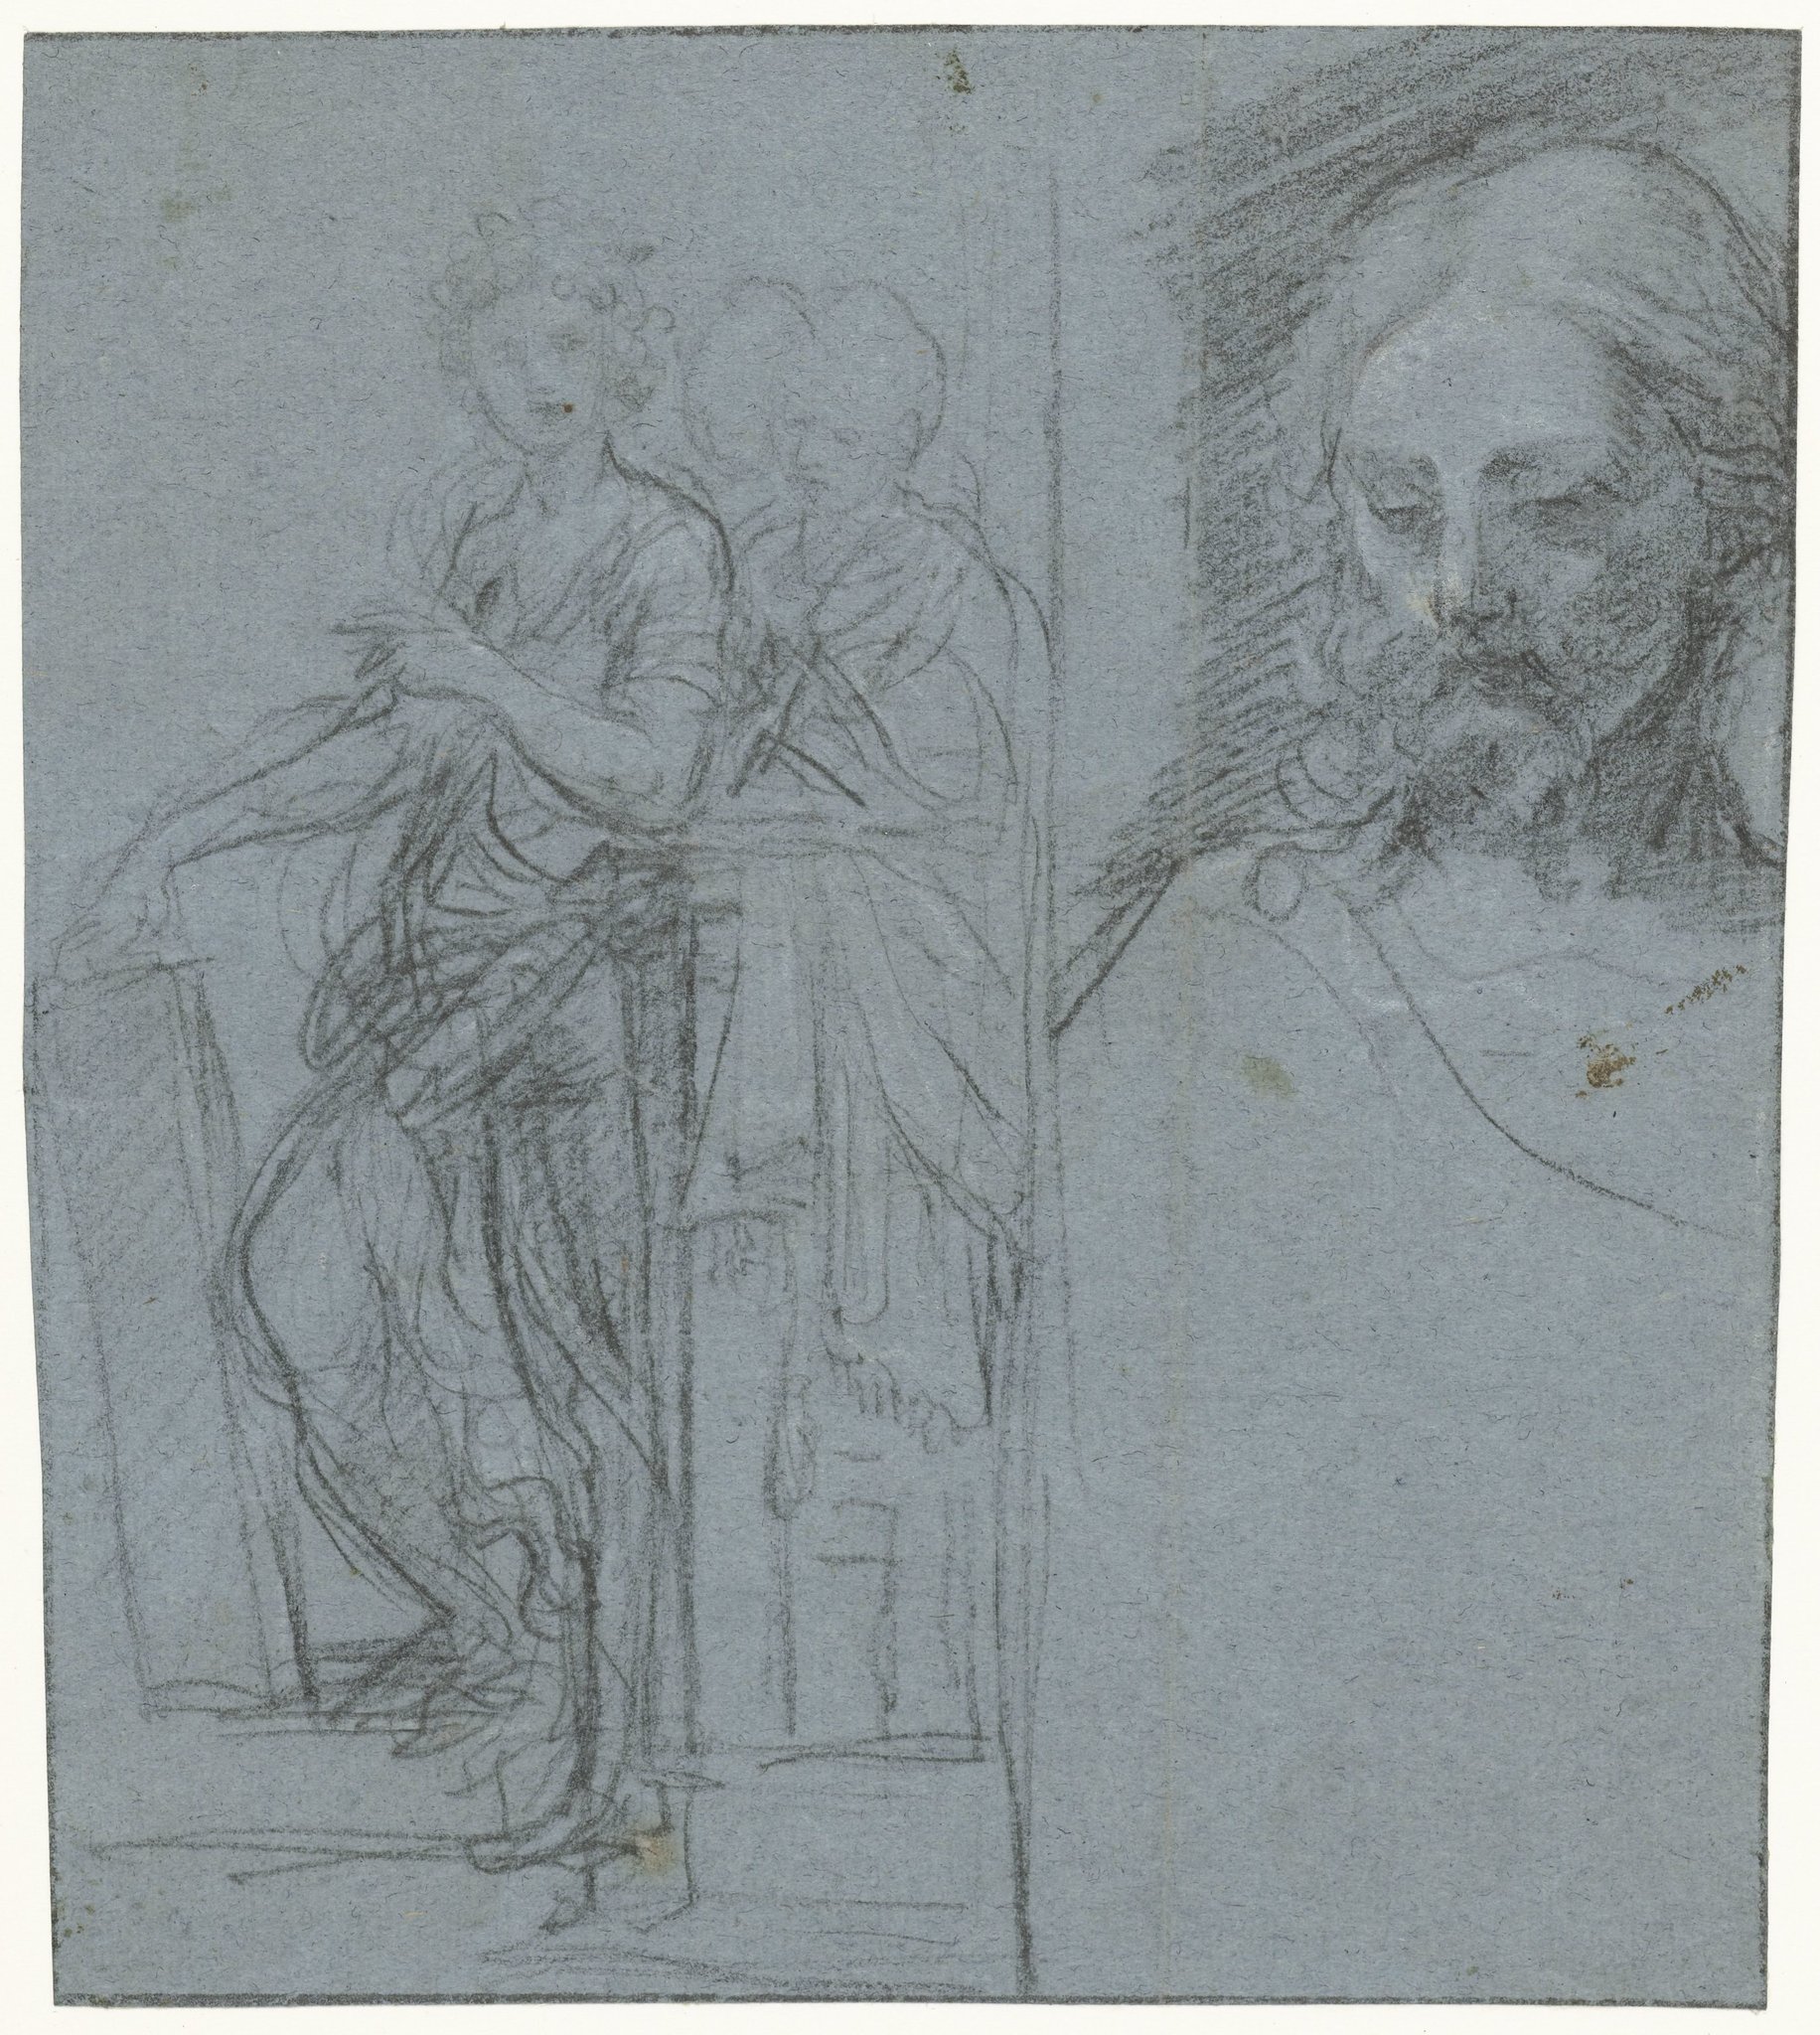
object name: drawing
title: Studieblad met staande vrouwen en een Christushoofd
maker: flaminio torri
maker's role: draughtsman, print maker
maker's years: 1621-1661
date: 1631-1661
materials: chalk, paper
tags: christ as adult, standing figure - aa - female human figure